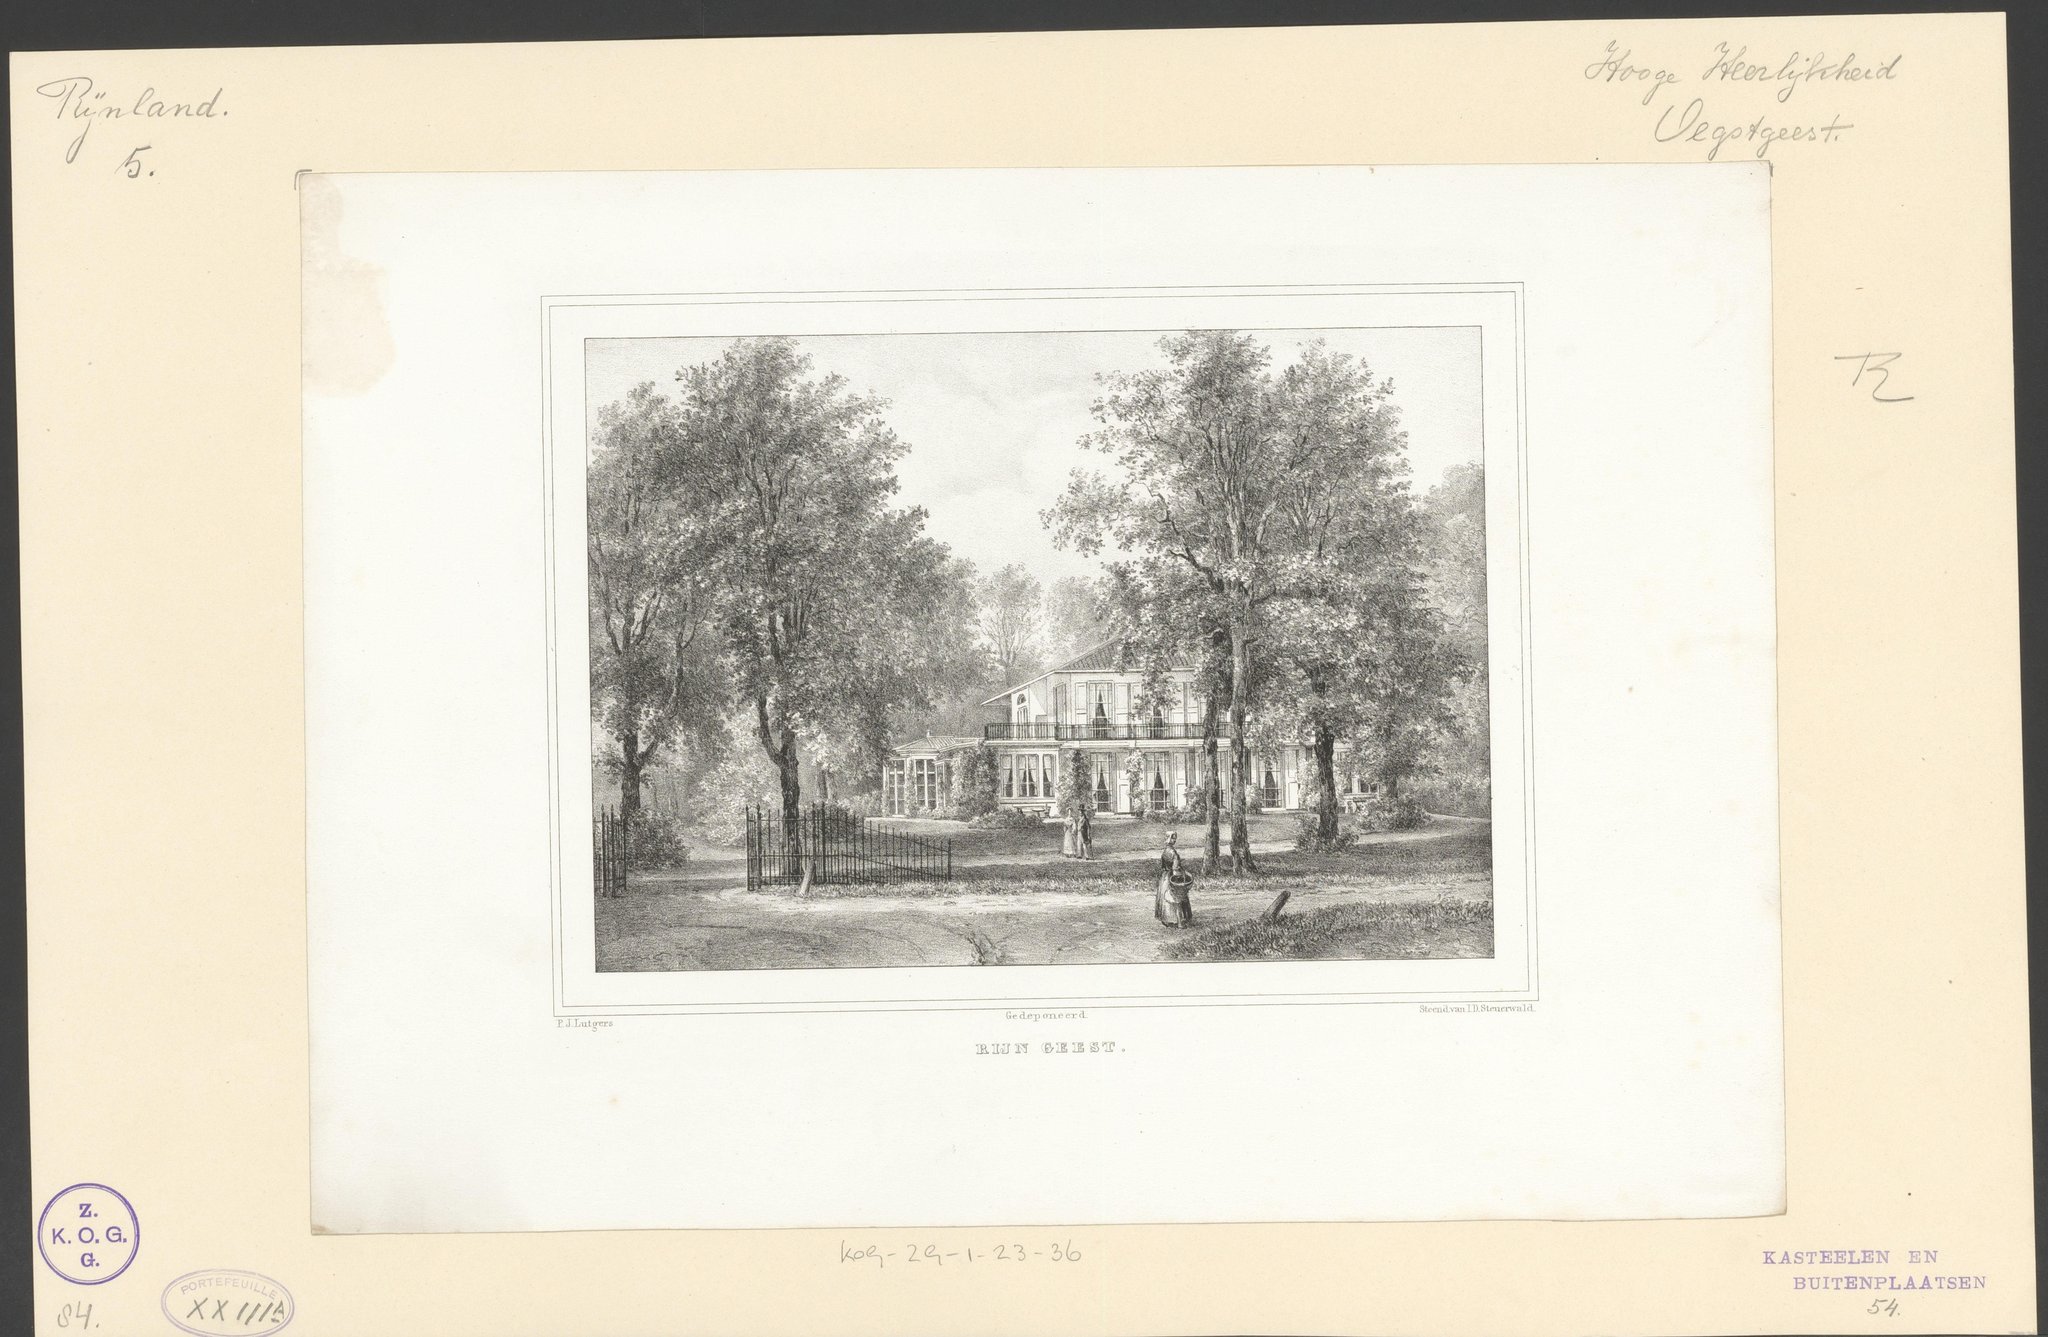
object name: print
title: Gezicht op de buitenplaats Rhijngeest te Oegstgeest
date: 1855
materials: paper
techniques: lithograph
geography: the hague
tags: trees, farm or solitary house in landscape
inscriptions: collector's mark: Lugt 1641, : ‘Gedeponeerd’, stamp, stamp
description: Onderwerpsrubrieken binnen de Atlas Zeden en Gewoonten: Zeden en Gewoonten in Engeren Zin, De Woning. Kastelen en buitenplaatsen. Holland.